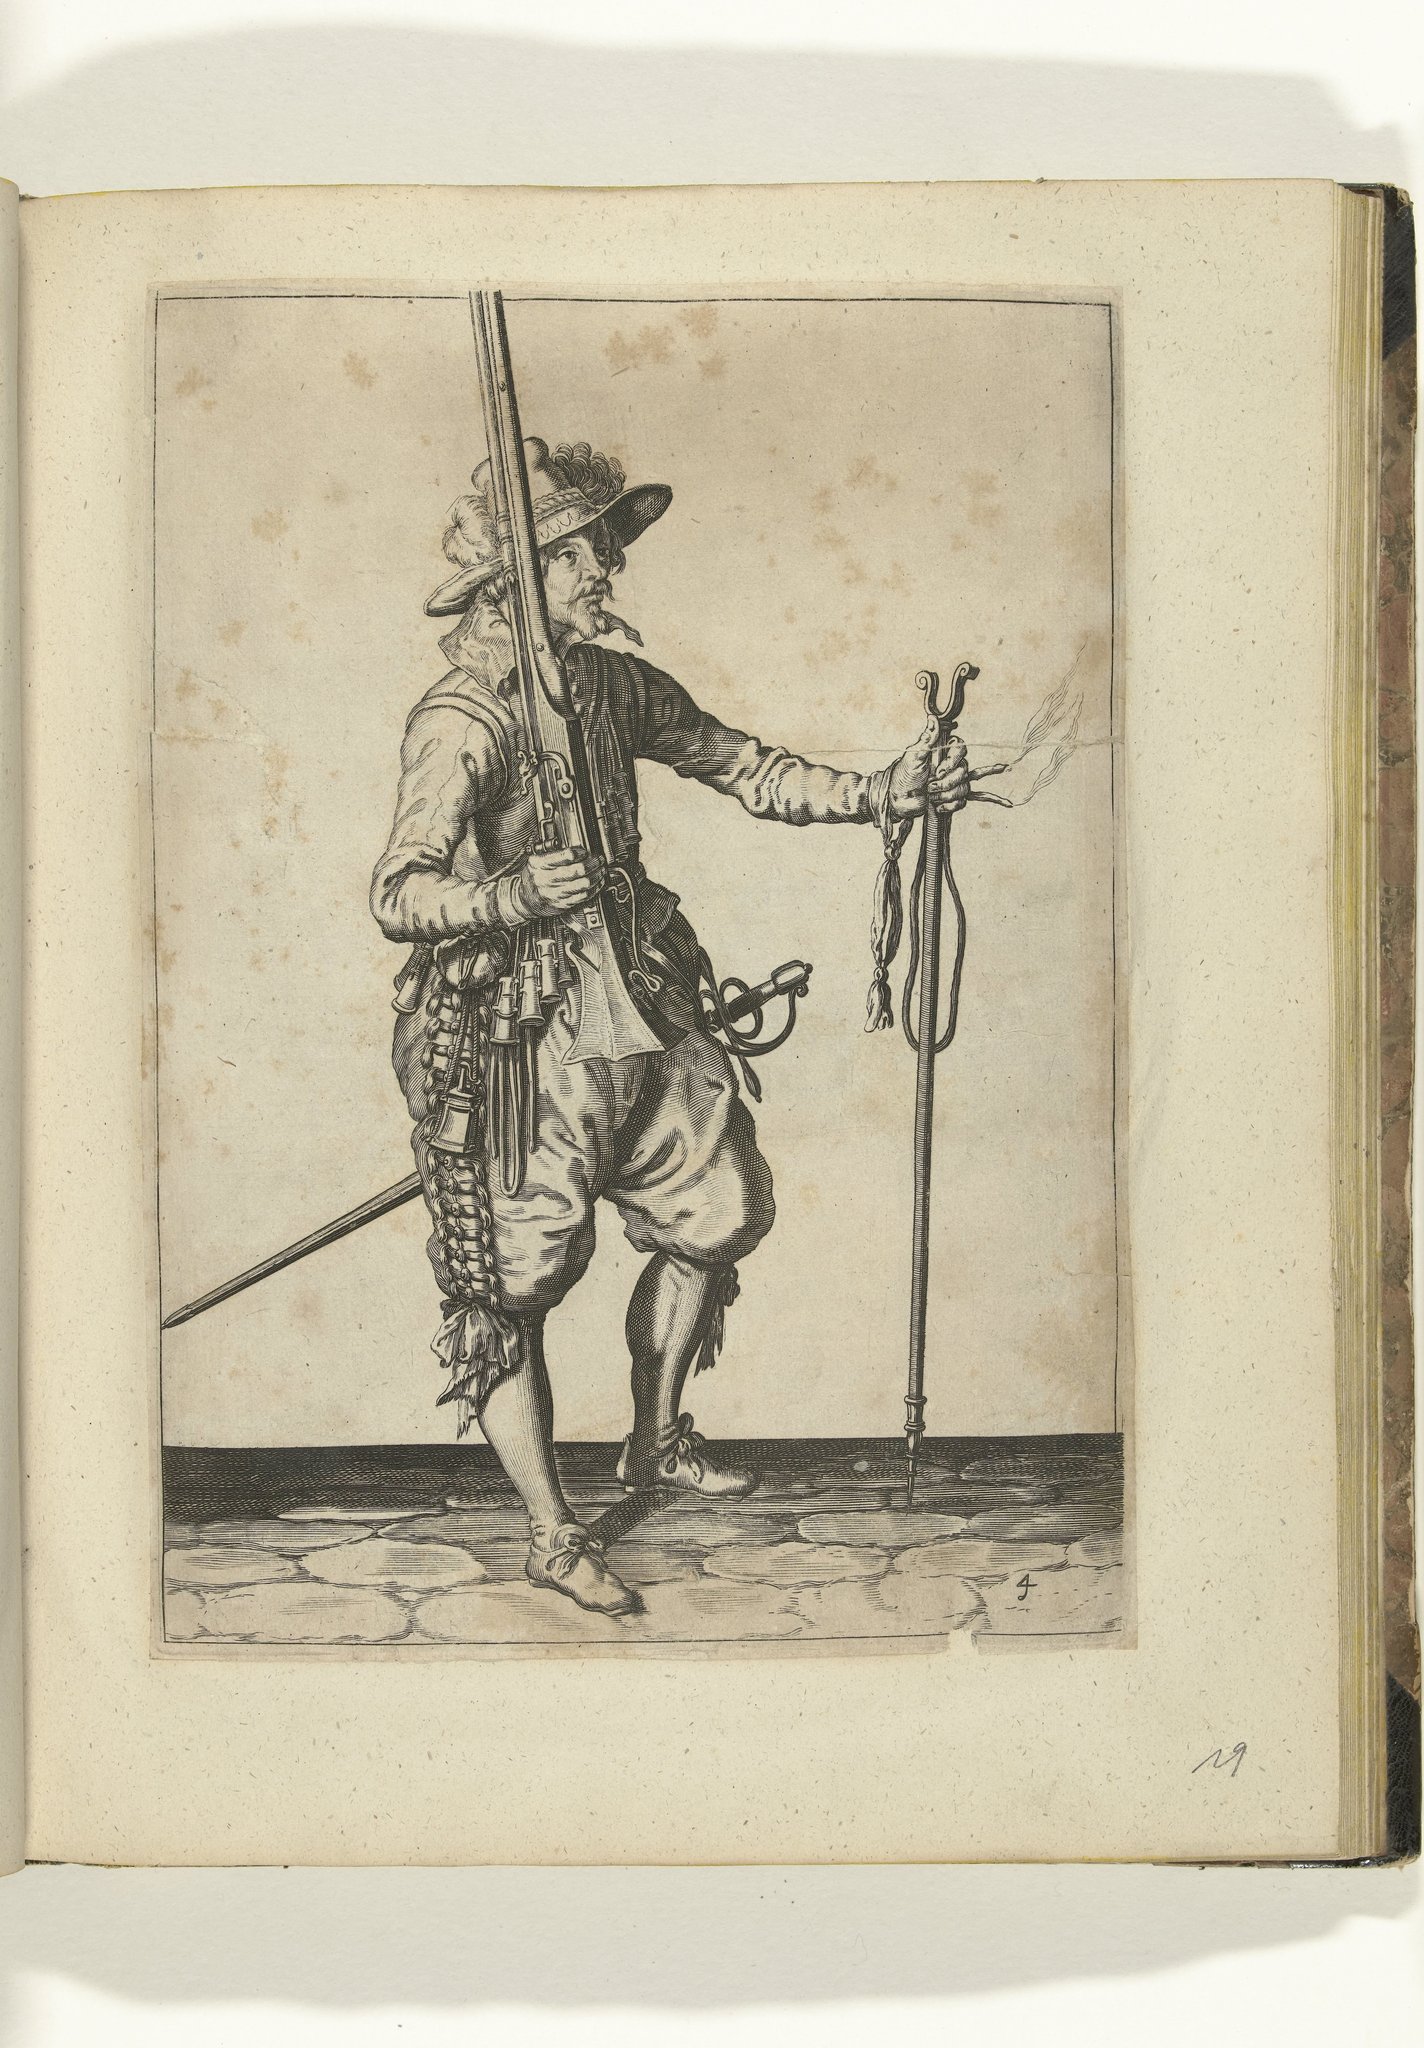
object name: print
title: Soldaat die zijn musket met zijn rechterhand rechtop vasthoudt, in zijn linkerhand het furket om zijn wapen op te plaatsen (nr. 4), ca. 1600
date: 1597-1608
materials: paper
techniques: engraving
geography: northern netherlands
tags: the hague, maurice (prince of orange), handling of weapons ~ military training, weapons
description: Een soldaat, ten voeten uit, naar rechts, die een musket (een bepaald type vuurwapen) met zijn rechterhand vasthoudt, de loop omhoog wijzend (nr. 4), ca. 1600. In zijn uitgestoken linkerhand een brandende lont en een furket (musketvork), waarop hij zijn wapen kan plaatsen. Plaat 4 in de instructies voor het hanteren van het musket: Shorte instruction for the figures, so much concerneth the right use of muskett. Onderdeel van de illustraties in een Engelse editie van J. de Gheyns Wapenhandelinghe: J. de Gheyn, The exercise of armes for calivres, muskettes and pikes after the ordre of Maurits Prince of Orange, 's-Gravenhage 1608. Krijgswezen rond 1600.